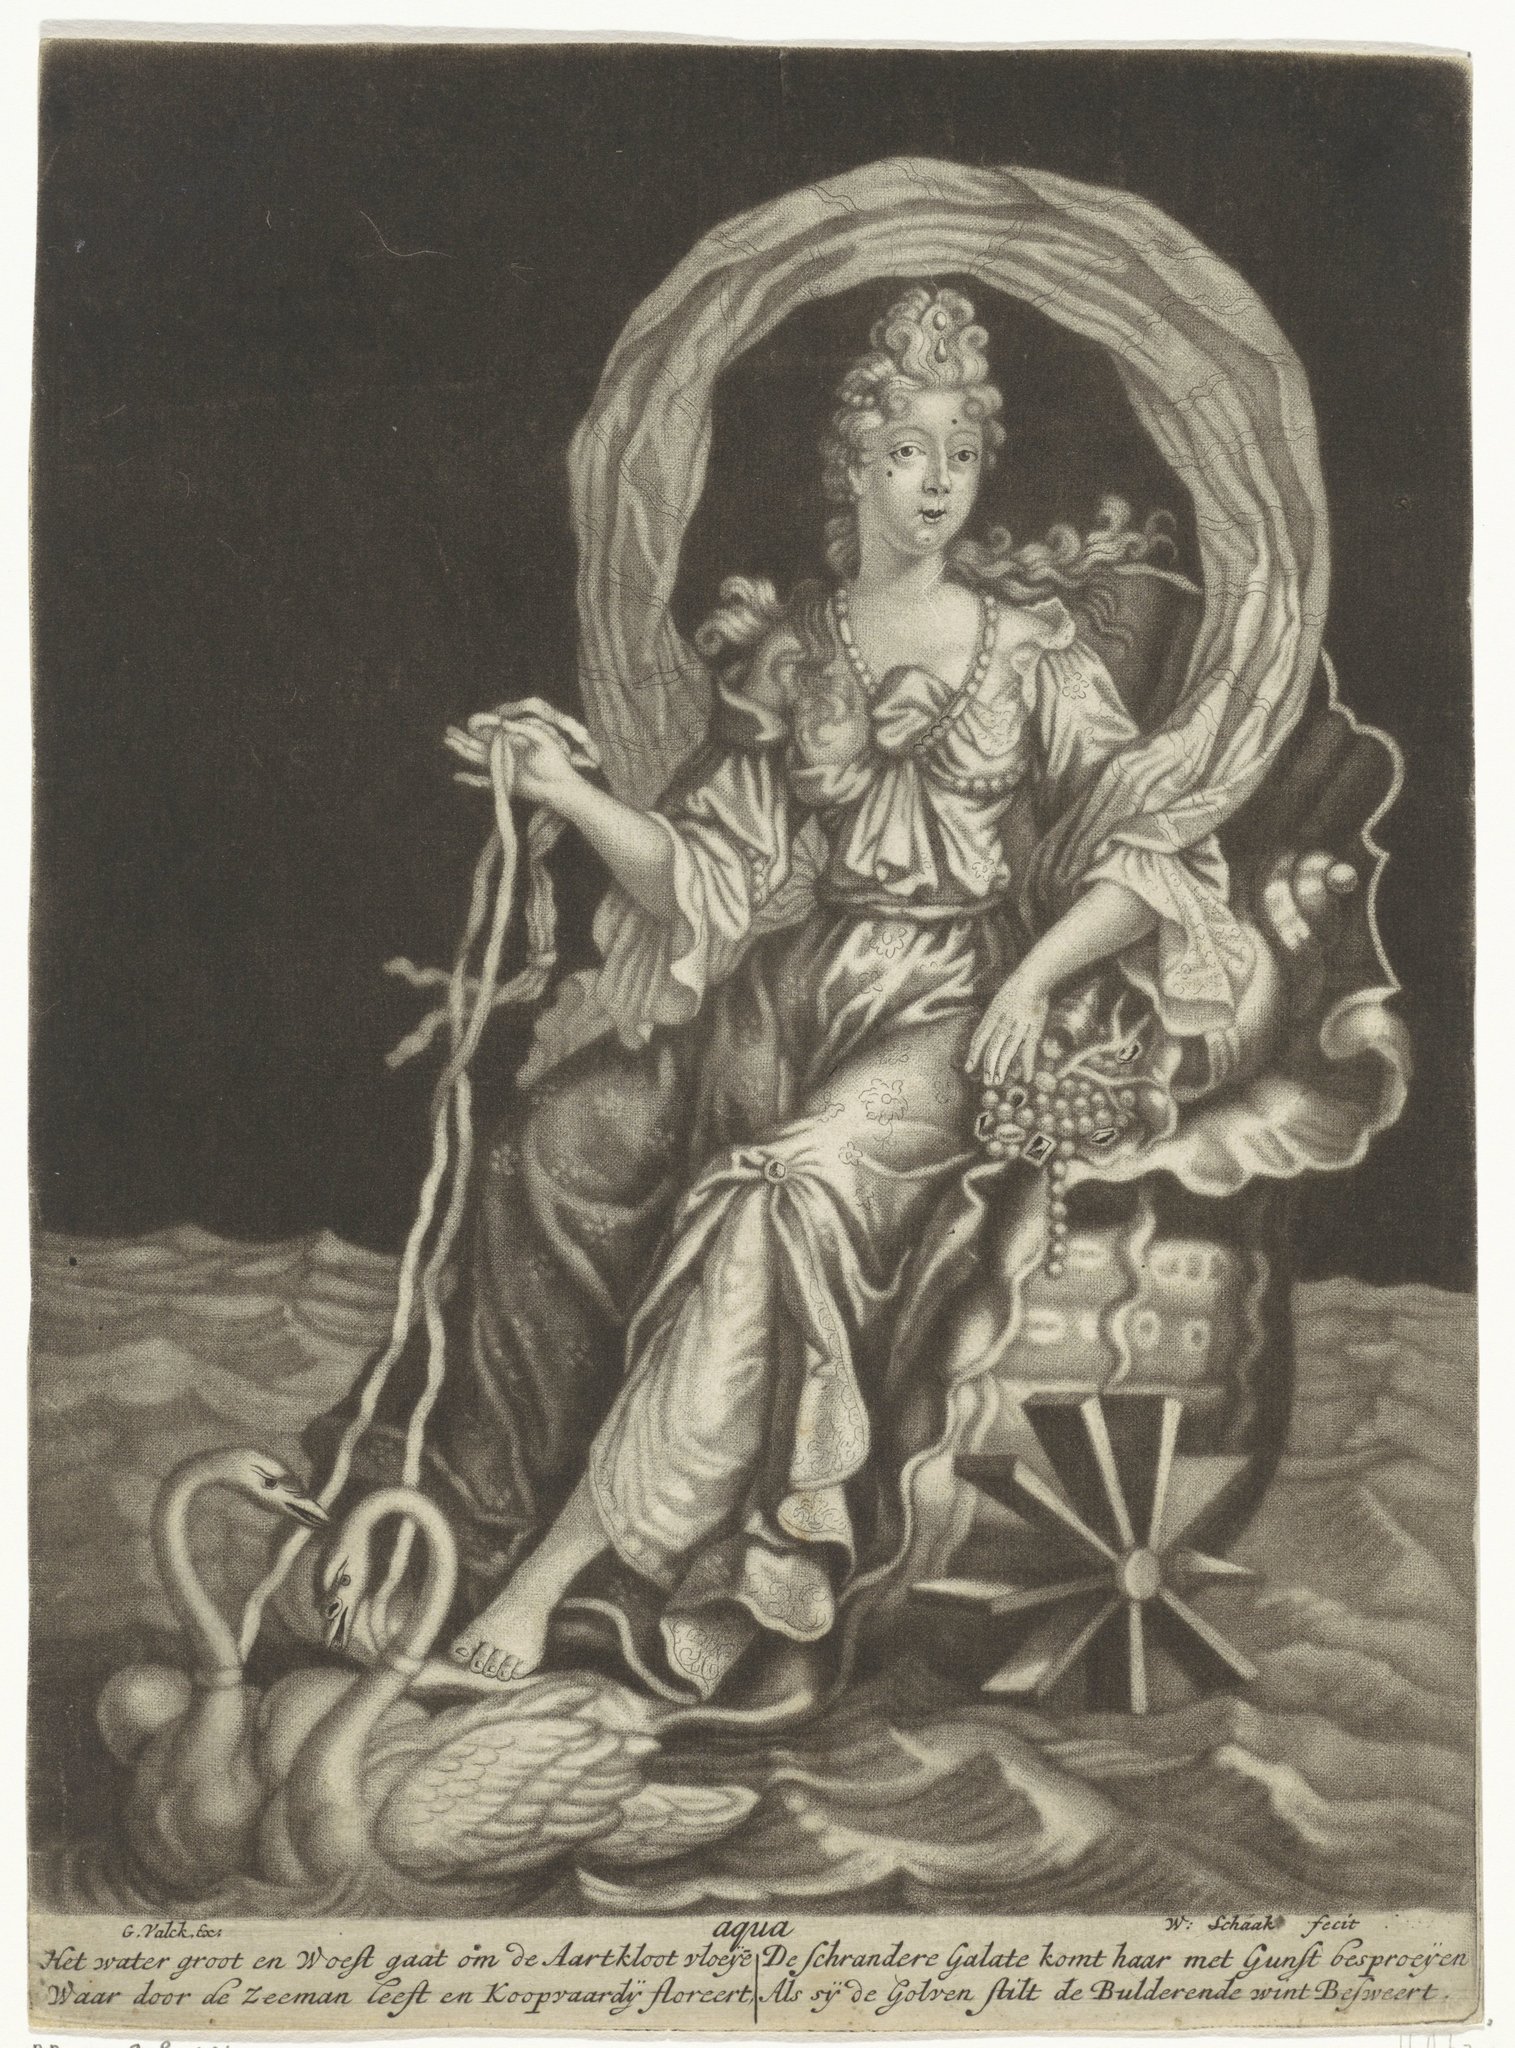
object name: print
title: Aqua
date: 1680-1726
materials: paper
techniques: engraving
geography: amsterdam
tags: water (one of the four elements), water-birds: swan, (story of) galatea; 'galatea' (ripa), pearl; pearl necklace (+ women's clothes)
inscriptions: collector's mark: Lugt 2228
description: Het element Water. De zeenimf Galatea, parels om de hals, zit op een triomfwagen die door zwanen door het water getrokken wordt.